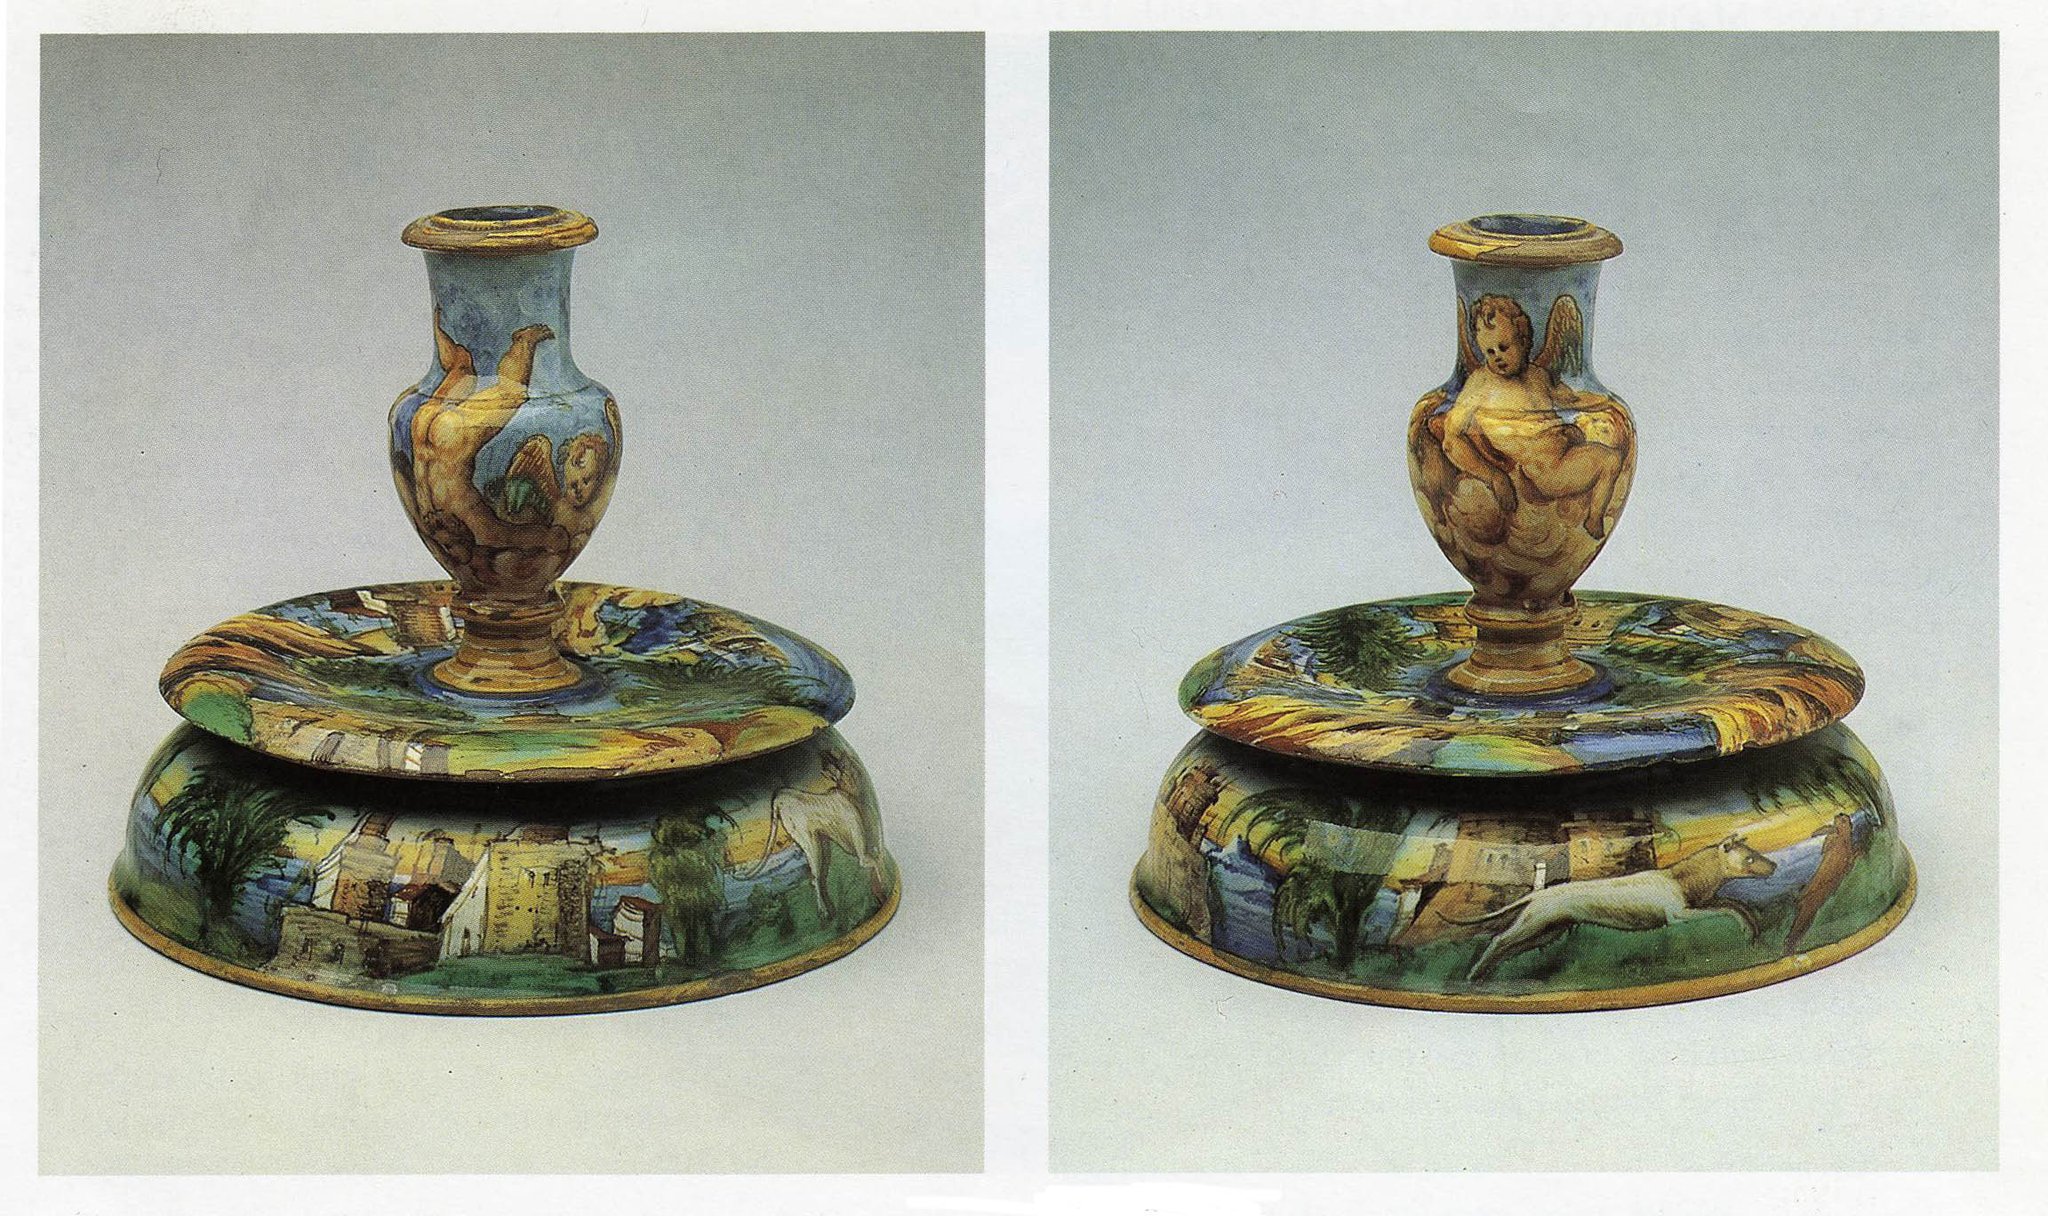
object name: candlestick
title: Pair of candlesticks (candelieri)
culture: italian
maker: workshop of guido durantino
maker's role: artist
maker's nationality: italian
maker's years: 1516-1581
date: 1550-1560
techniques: maiolica, glazing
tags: animals,putti